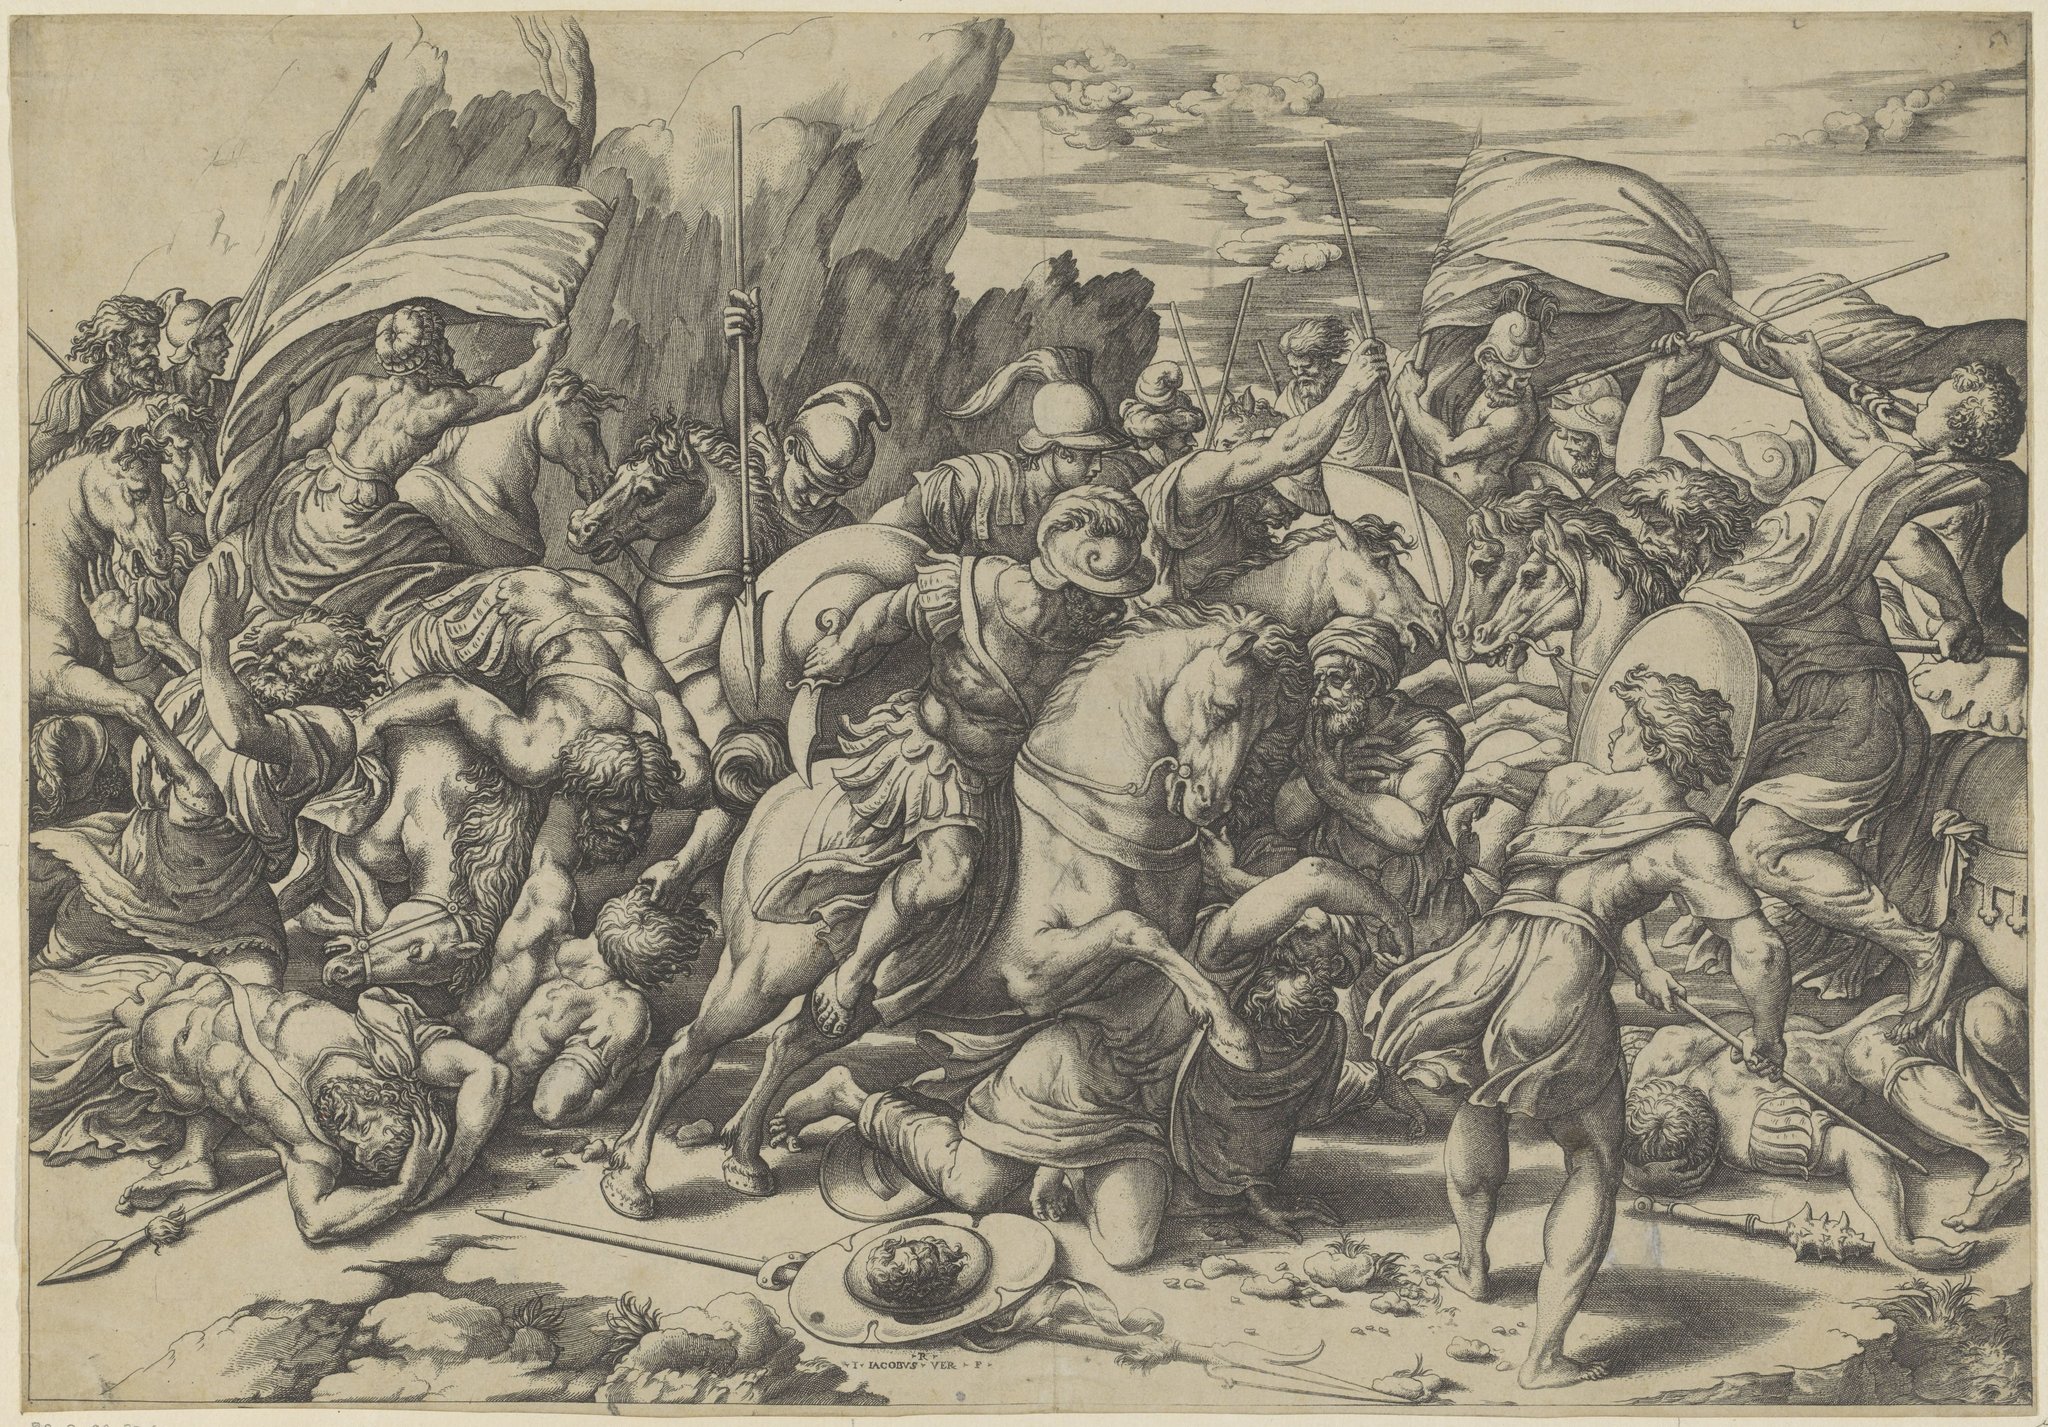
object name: print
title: Gevecht met schilden en lansen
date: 1515-1565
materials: paper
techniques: engraving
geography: italy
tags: battle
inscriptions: collector's mark: Lugt 240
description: Soldaten te paard en te voet in gevecht met lansen en schilden. Mogelijk de strijd tussen Romeinen en Barbaren.